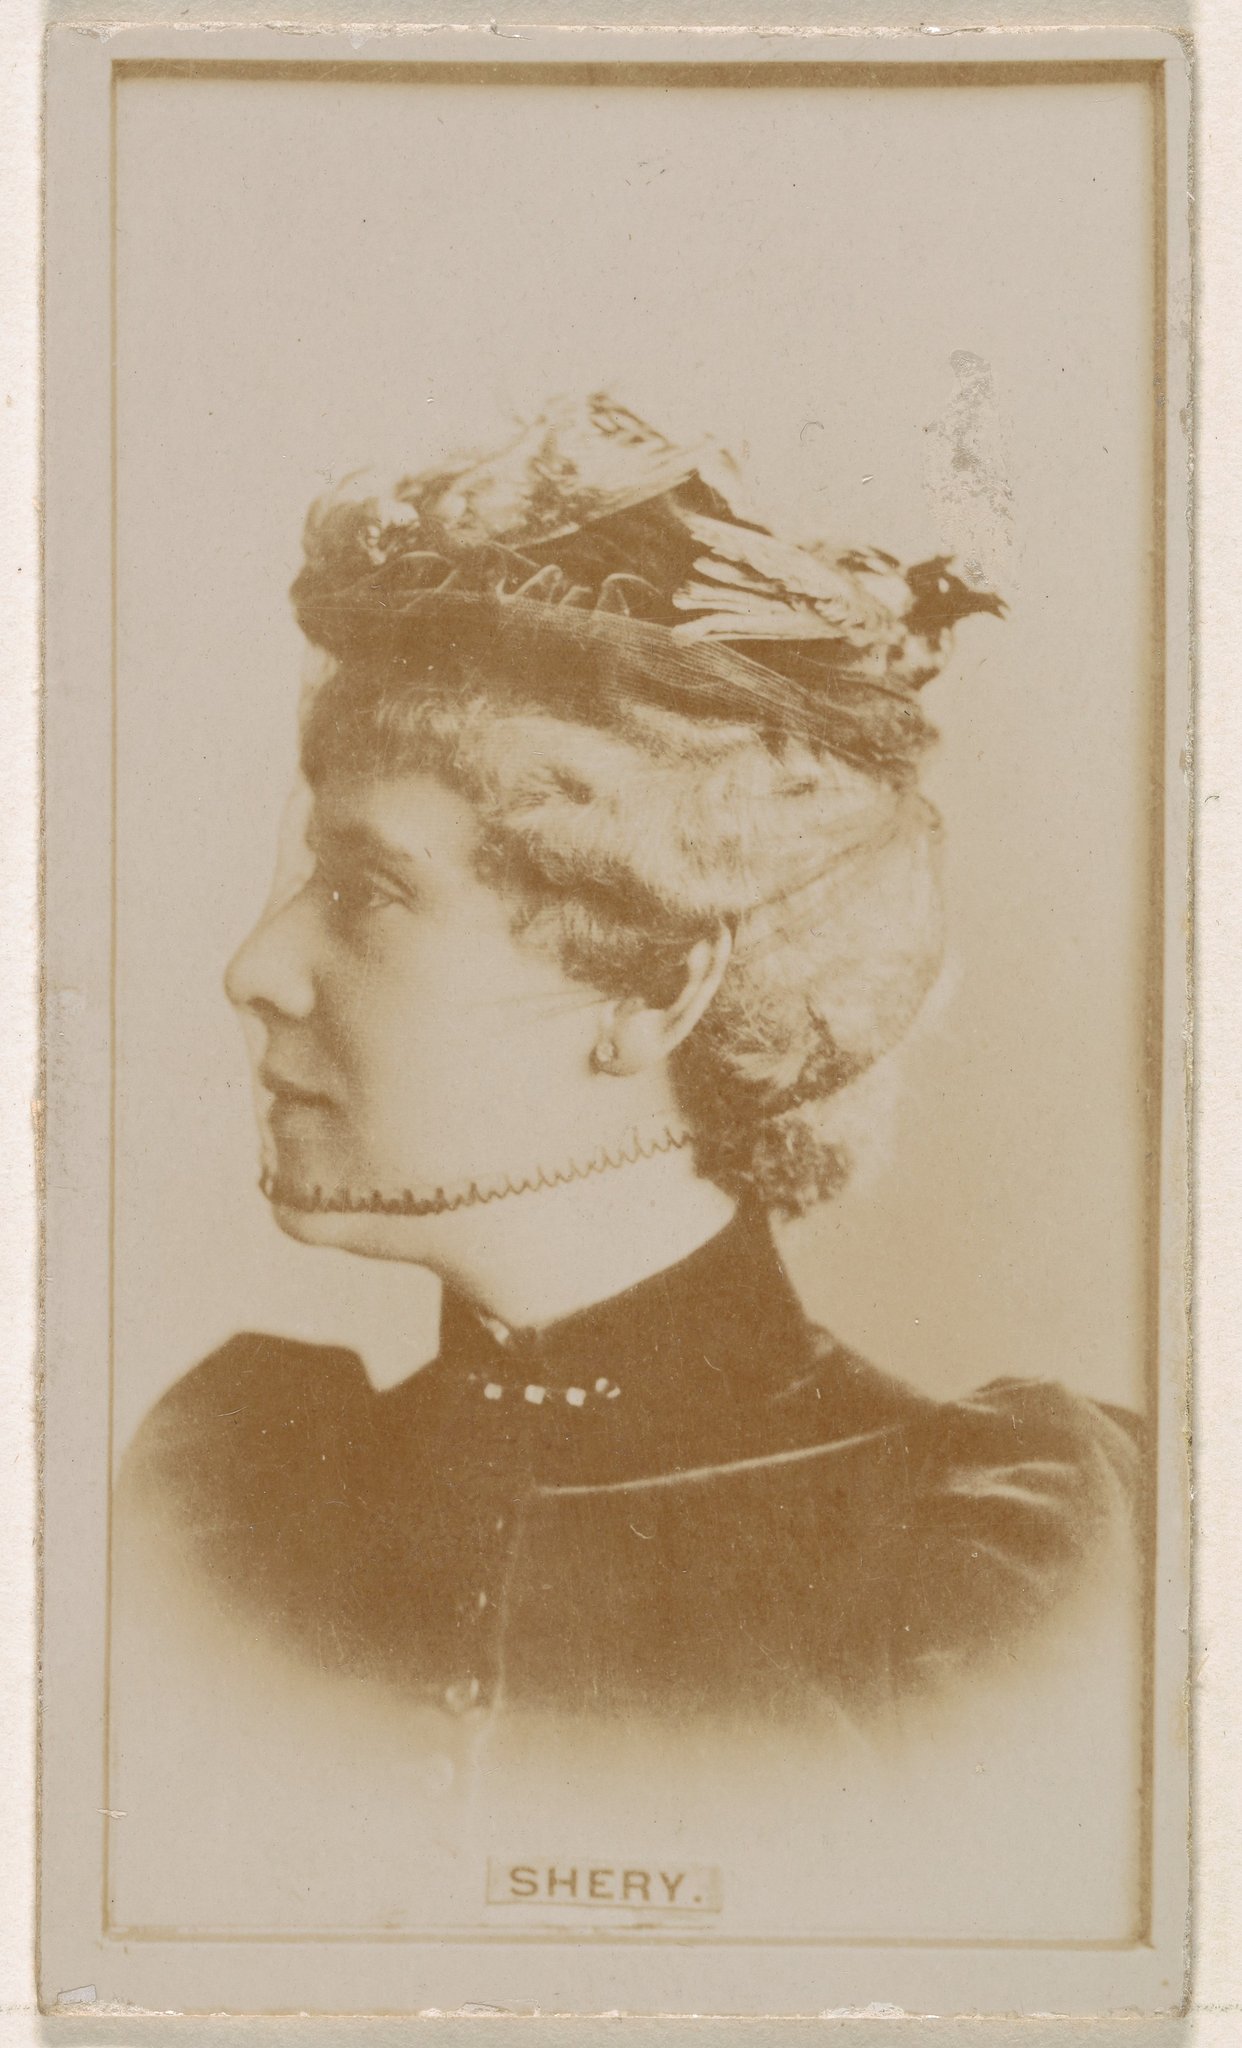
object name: photograph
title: Miss Shery, from the Actresses series (N245) issued by Kinney Brothers to promote Sweet Caporal Cigarettes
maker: kinney brothers tobacco company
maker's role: publisher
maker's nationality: american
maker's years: 1869-2011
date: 1890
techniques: albumen silver print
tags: women,actresses